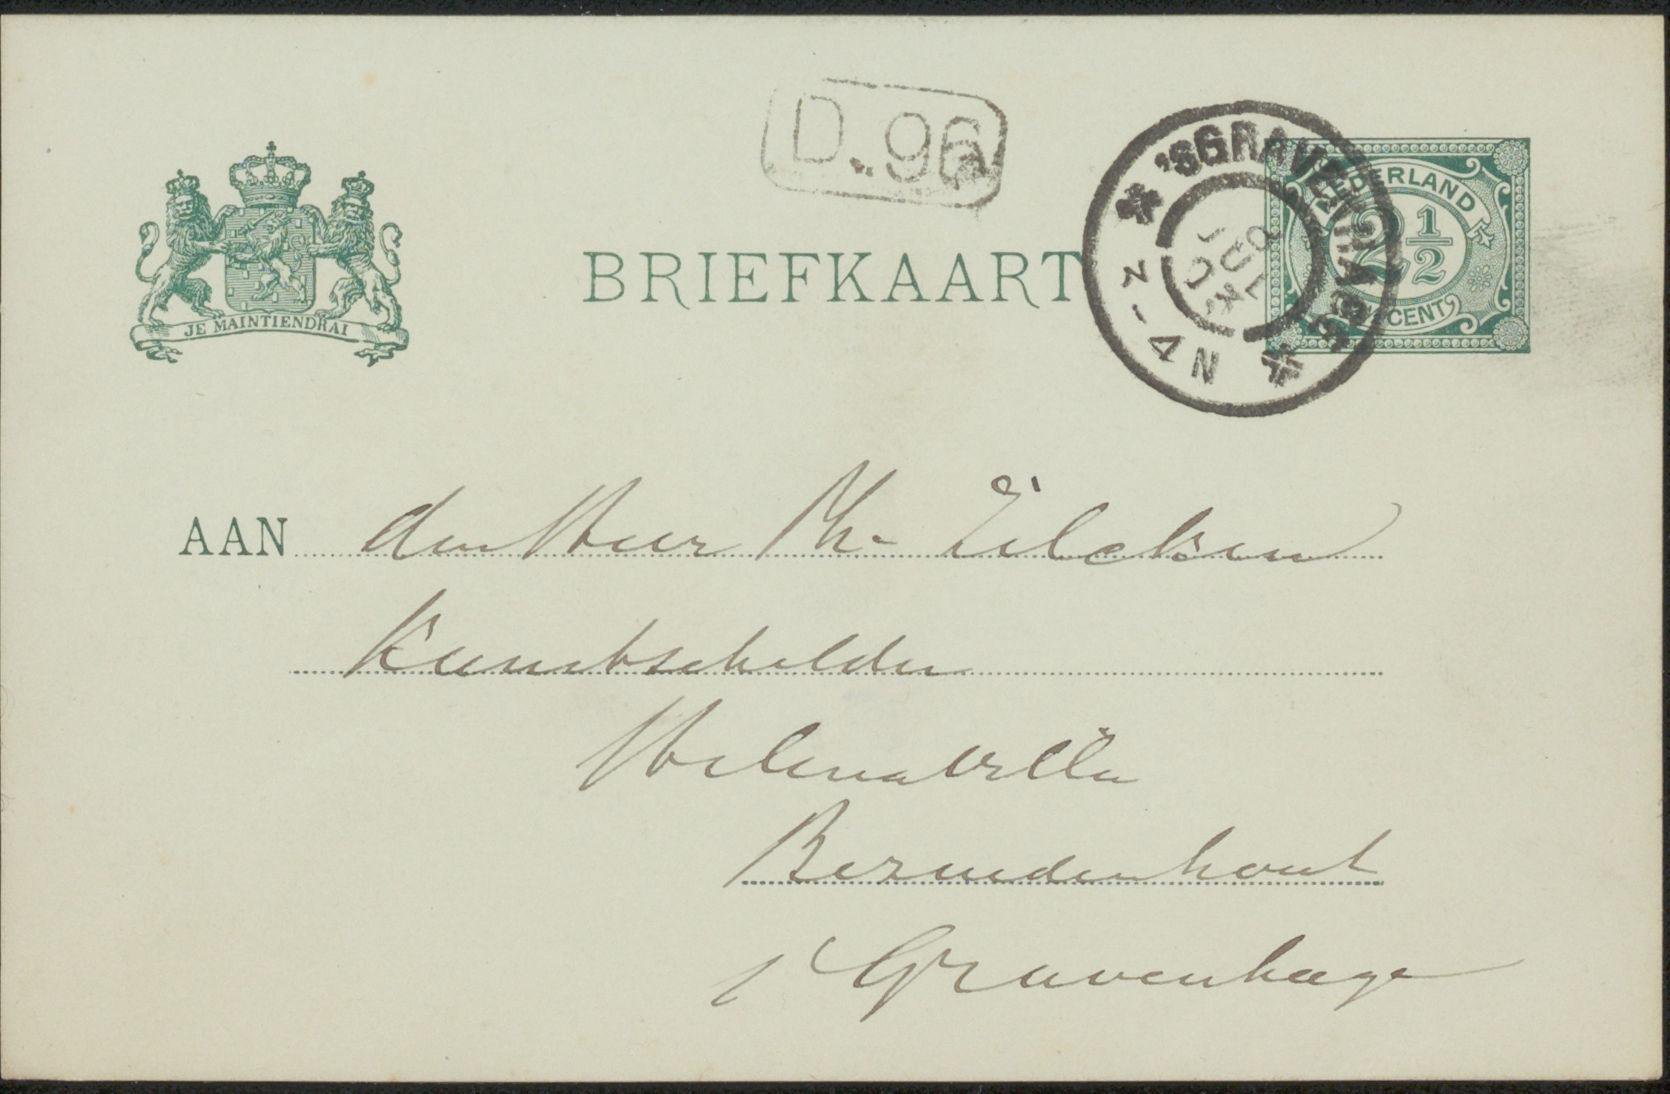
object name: postcard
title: Briefkaart aan Philip Zilcken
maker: hendrik willem mesdag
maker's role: draughtsman, painter, print maker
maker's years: 1831-1915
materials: cardboard, ink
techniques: pen, writing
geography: the hague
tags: philip zilcken